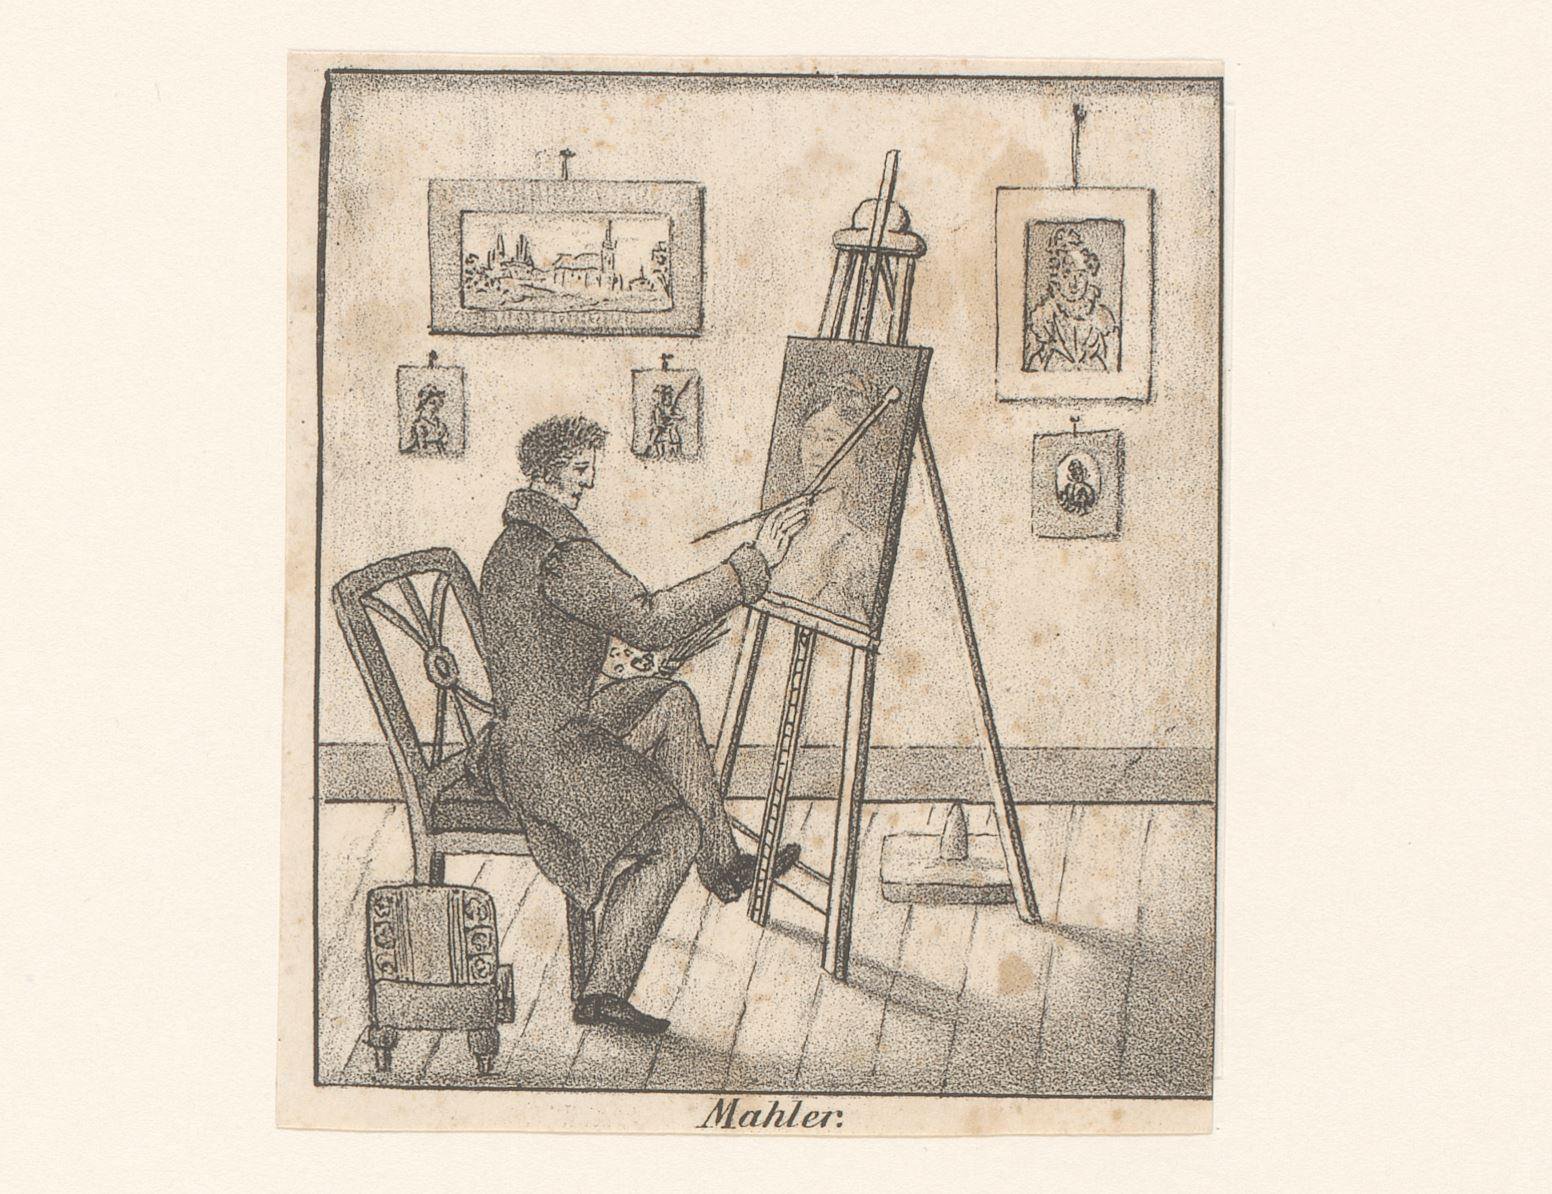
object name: print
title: Schilder achter zijn ezel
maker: Anonymous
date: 1750-1850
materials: paper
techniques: soft ground etching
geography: germany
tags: painter at work, in his studio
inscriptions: collector's mark: Lugt 2228